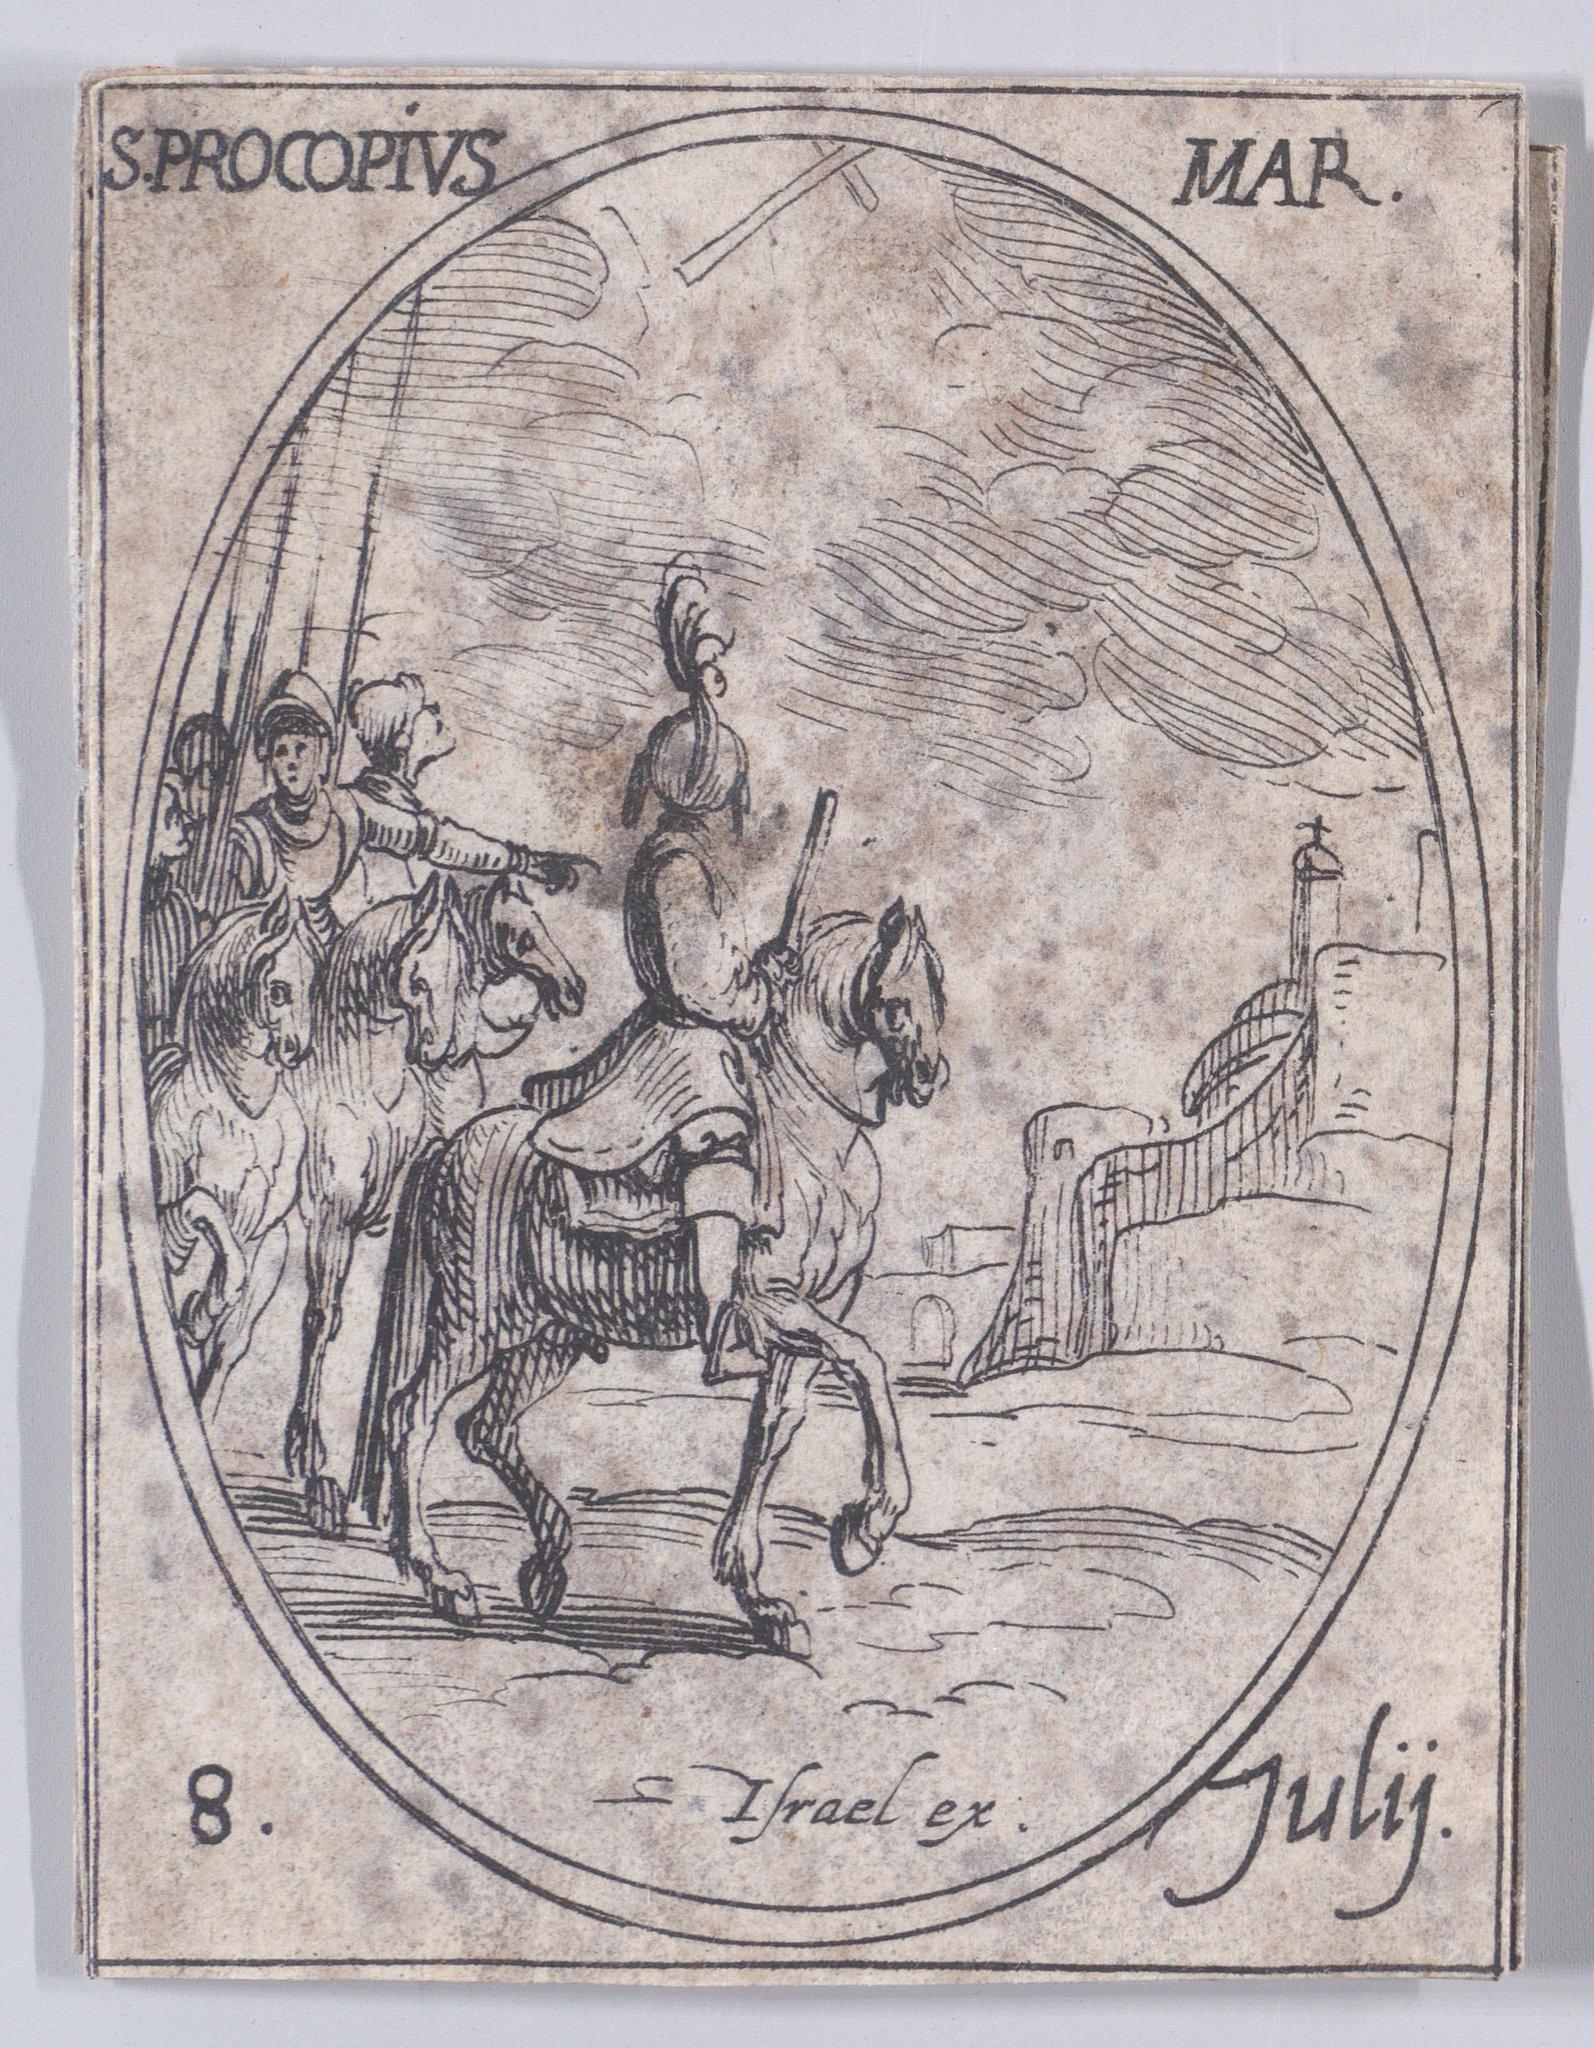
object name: print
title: S. Procope, martyr (St. Procopius, Martyr), July 8th, from "Les Images De Tous Les Saincts et Saintes de L'Année" (Images of All of the Saints and Religious Events of the Year)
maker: jacques callot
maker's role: artist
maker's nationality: french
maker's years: 1592-1635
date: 1636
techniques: etching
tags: men,horses,saints